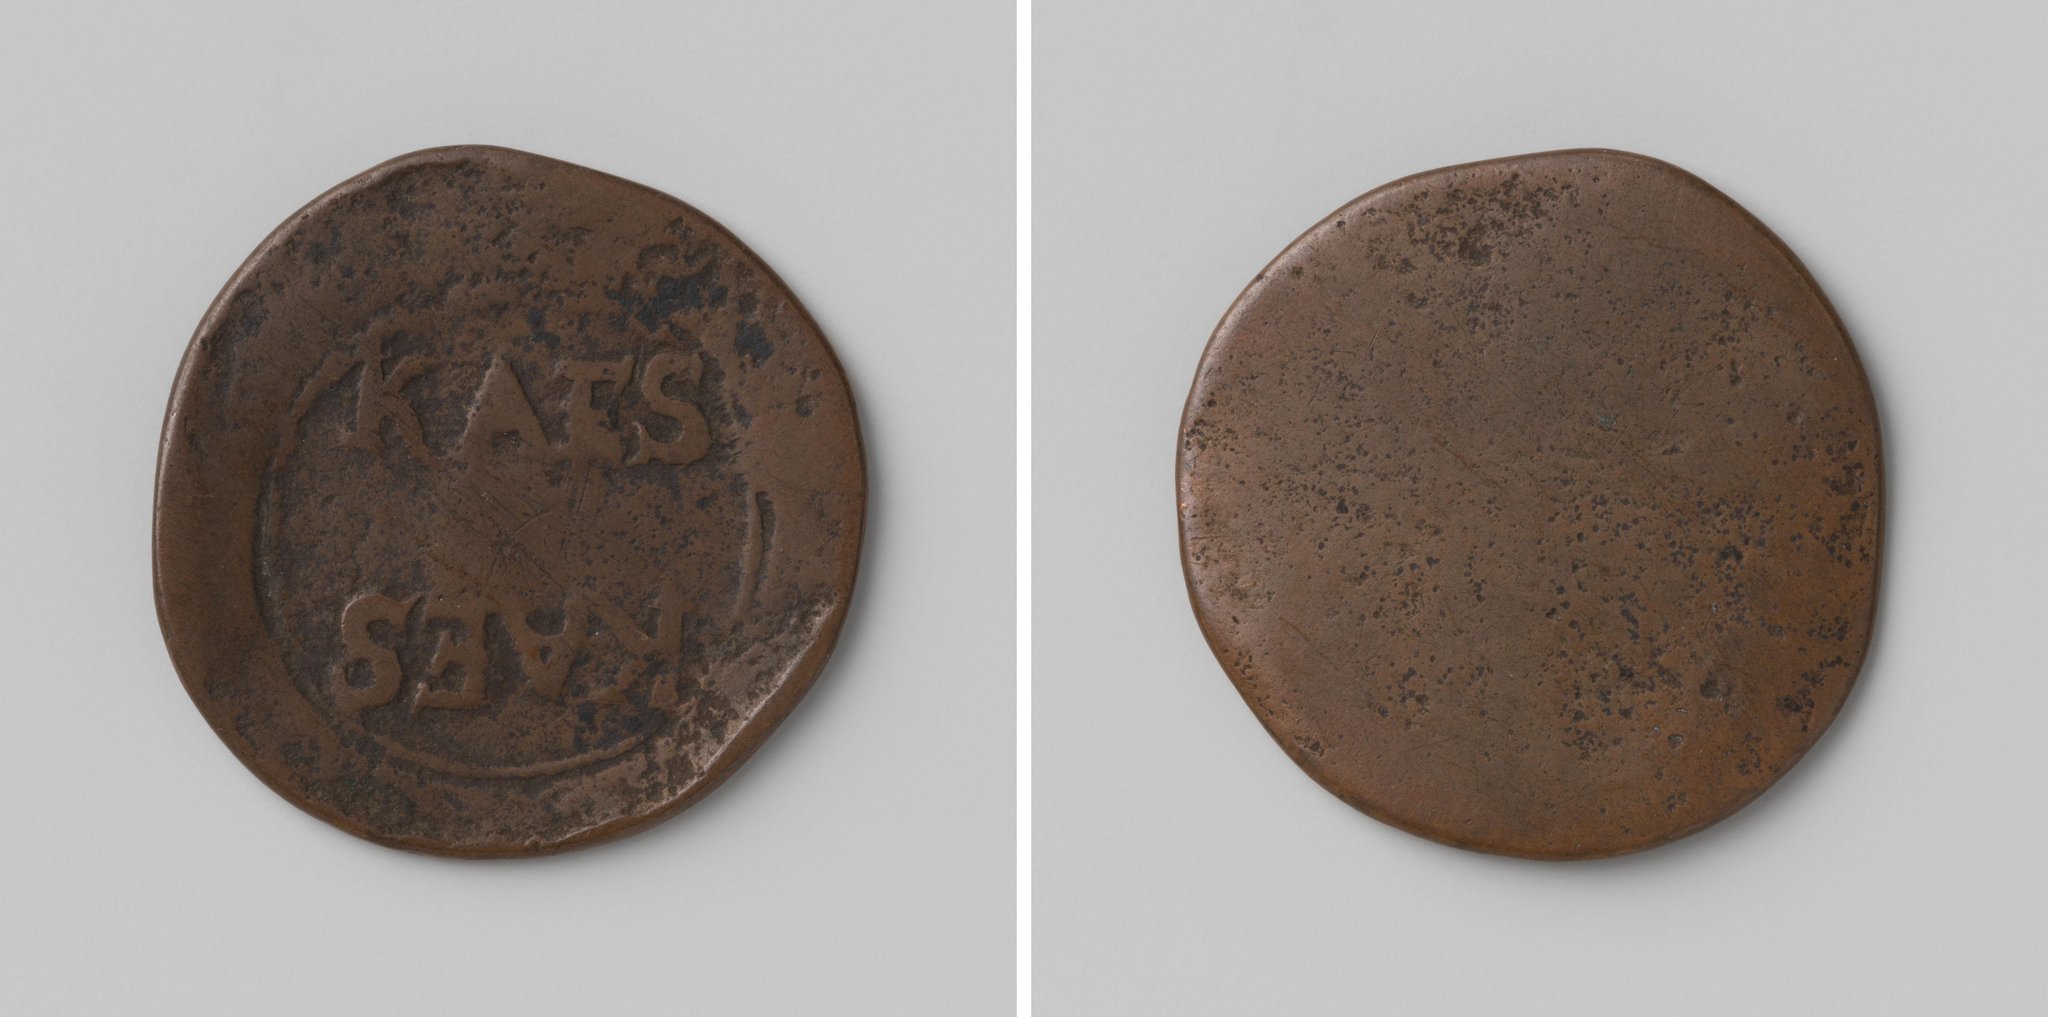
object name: armenloodje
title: Loodje dat bij uitdeling recht gaf op kaas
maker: Anonymous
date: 1600-1800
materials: copper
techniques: striking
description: Eenzijdig koperen loodje. Voorzijde: opschrift binnen cirkel. Keerzijde: blanco